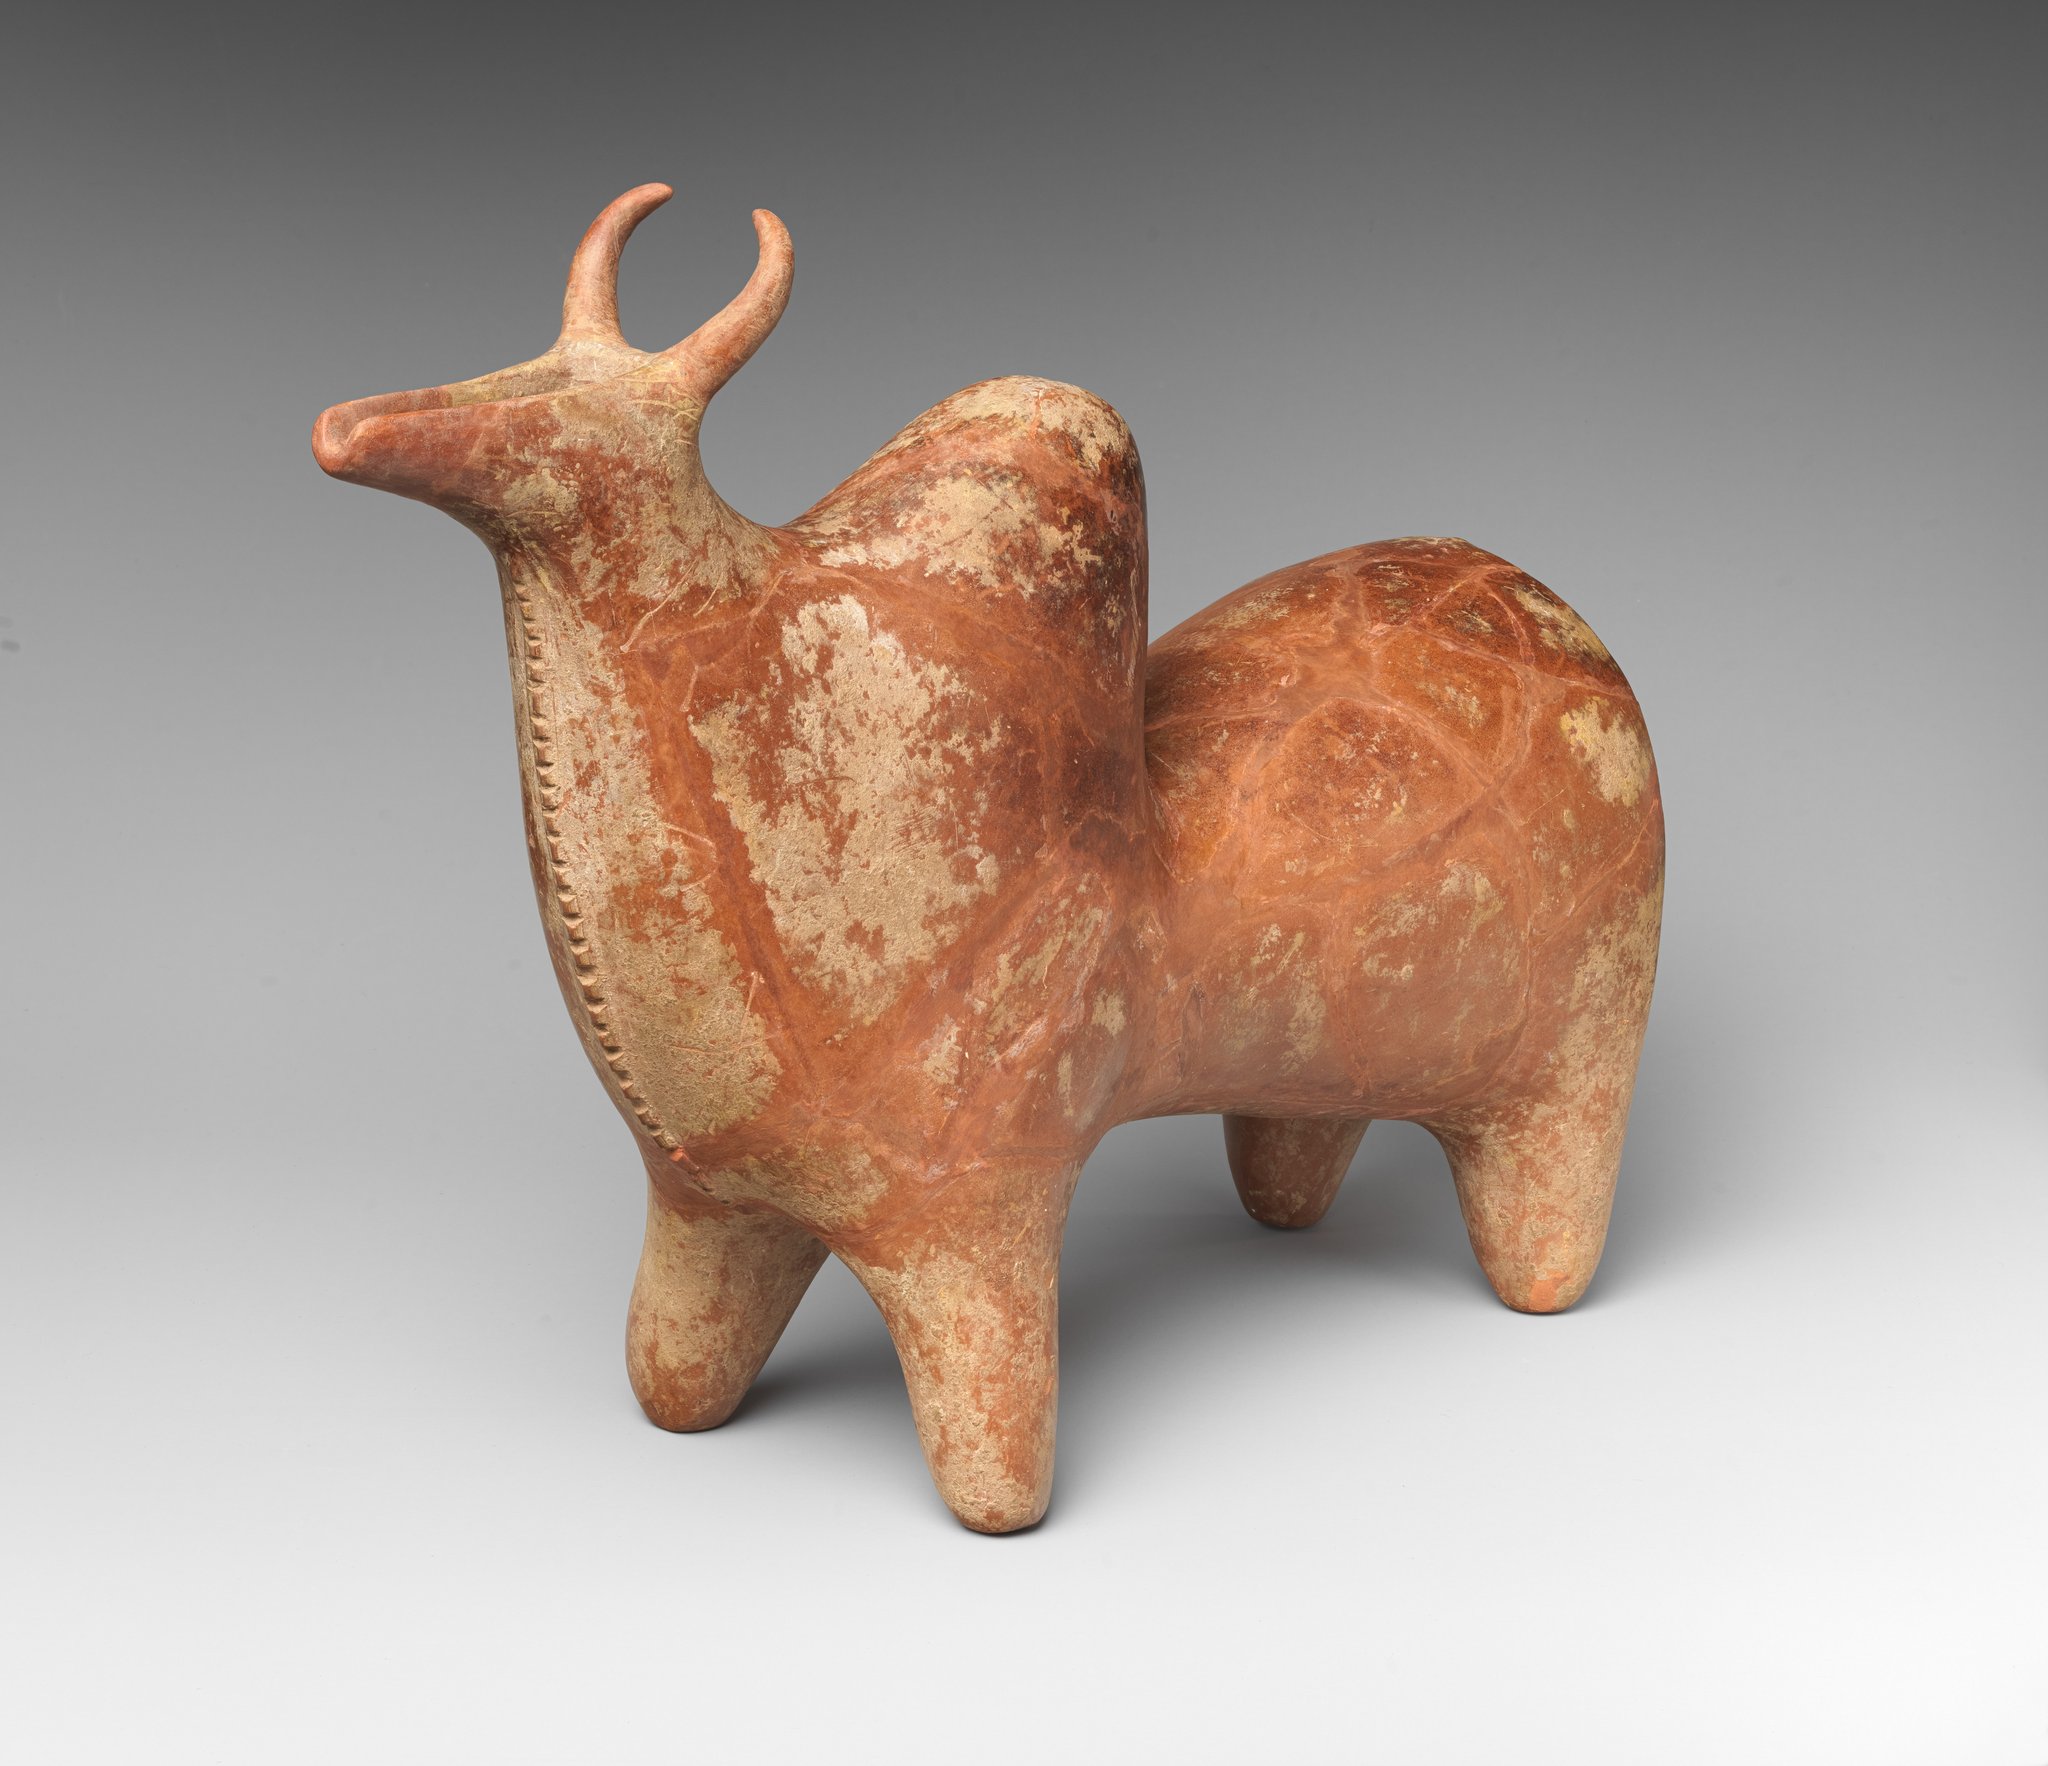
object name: vessel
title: Spouted vessel in the shape of a zebu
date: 1000 BCE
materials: ceramic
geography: northwestern iran, caspian region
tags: animals